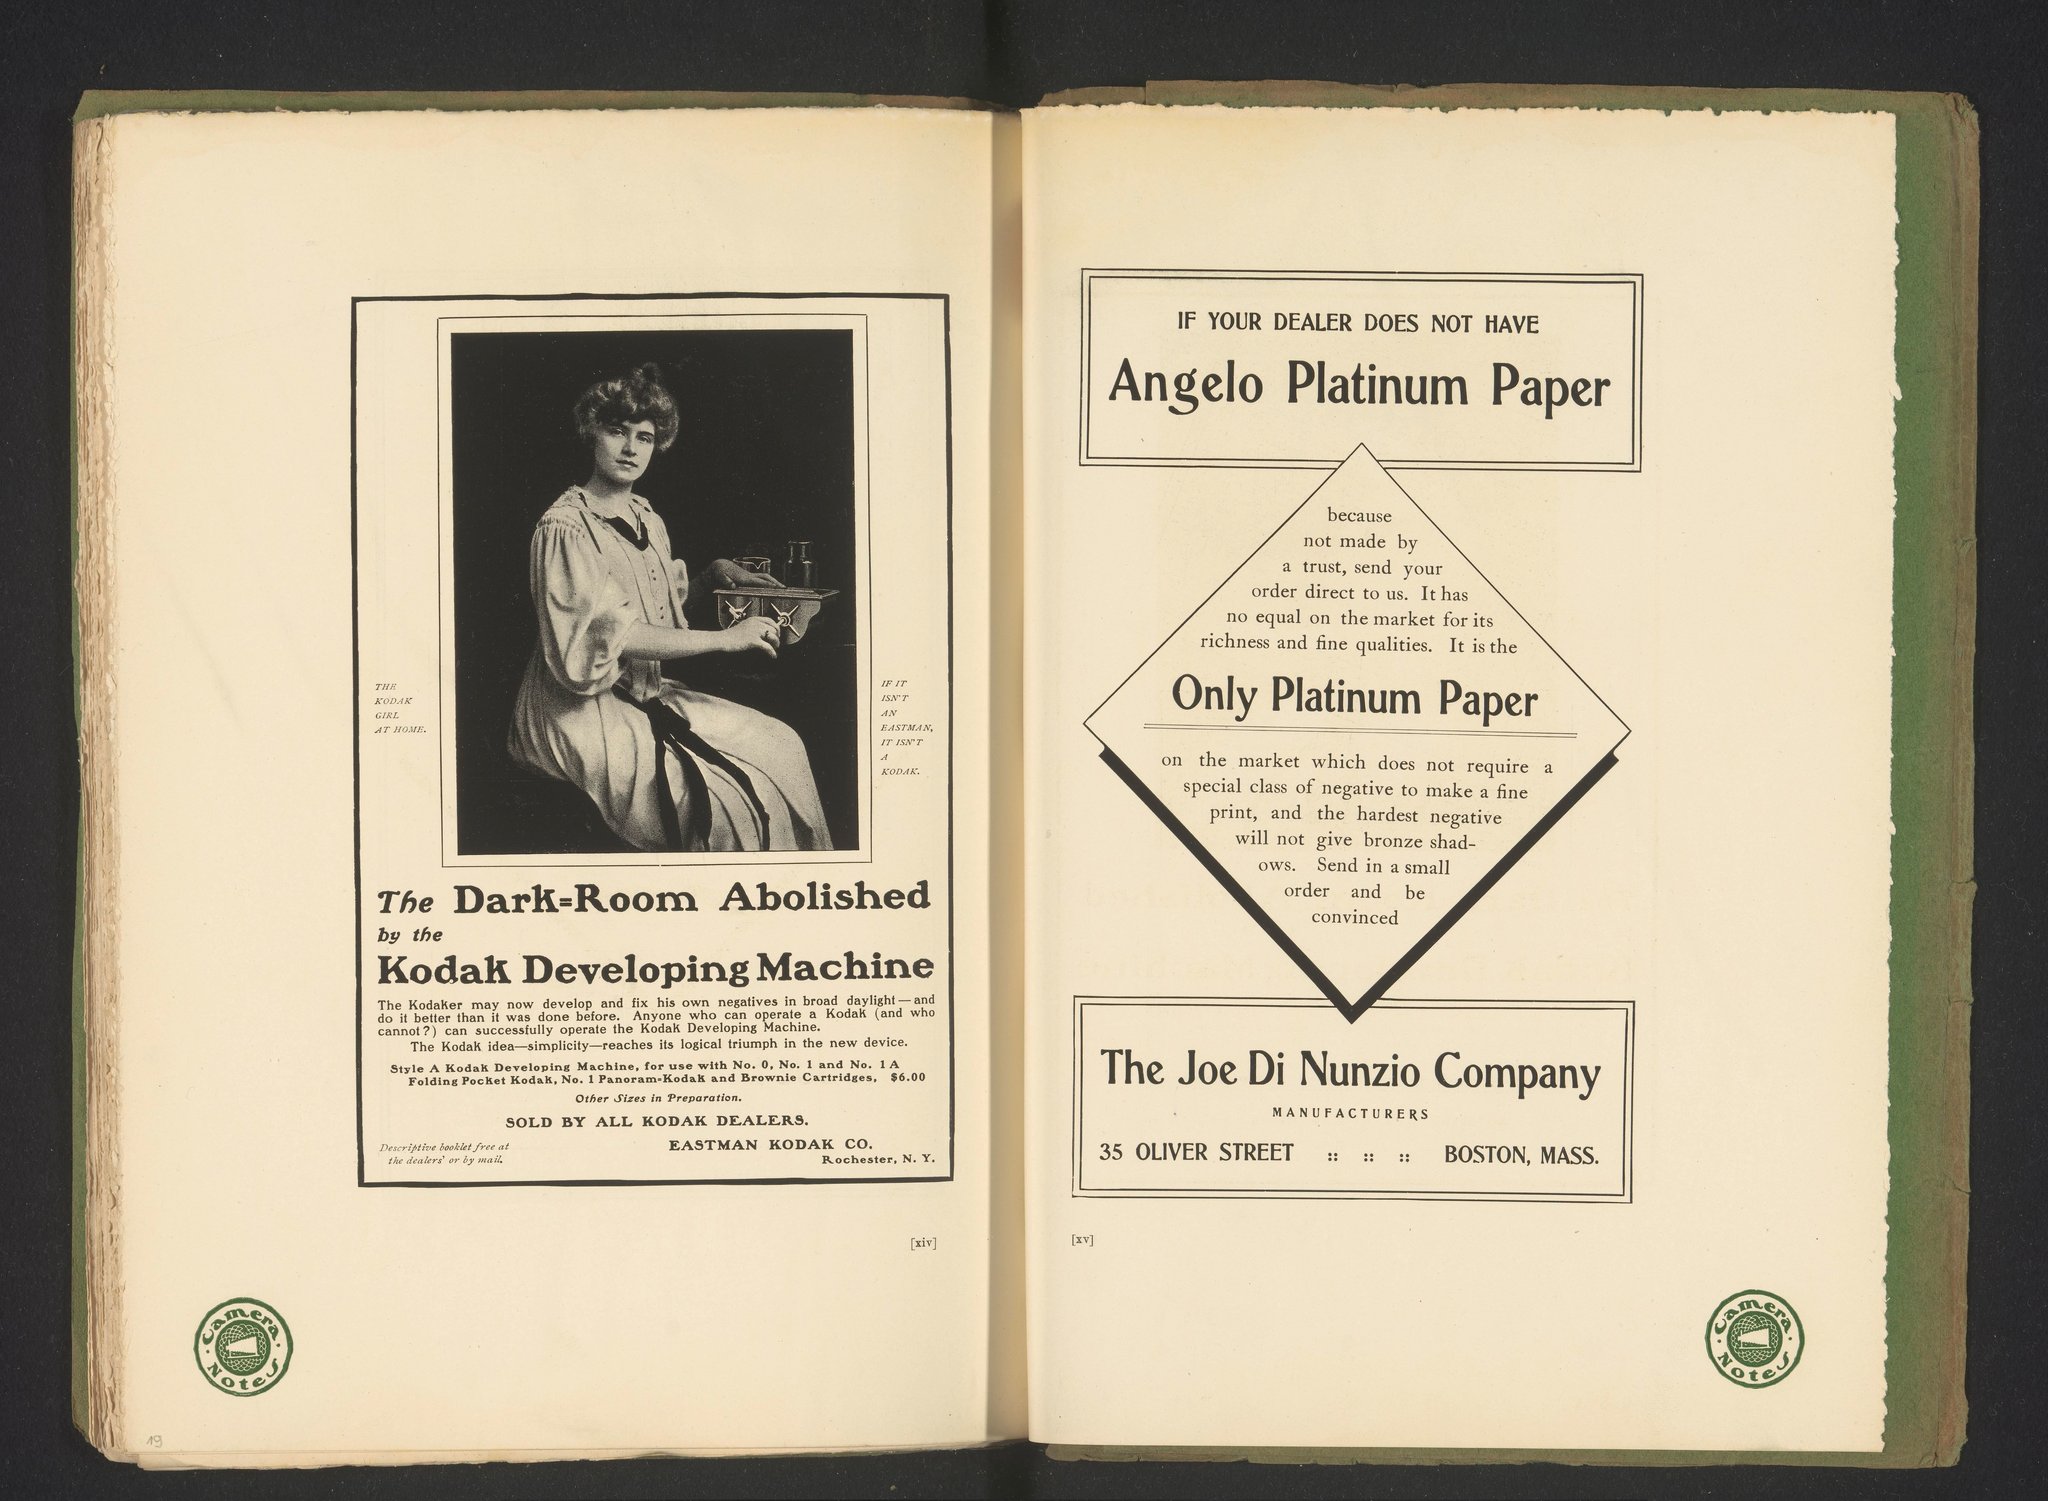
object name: page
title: The Kodak Girl at Home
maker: Anonymous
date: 1897-1902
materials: paper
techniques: autotype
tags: historical persons not known by name - bb - woman, developing ~ film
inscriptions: inscription: ‘If it/ isn't/ an/ Eastman,/ it isn't/ a/ Kodak.’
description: Prent in katern advertenties achterin boek. Prent is onderdeel van een reclameboodschap van de Eastman Kodak Company.